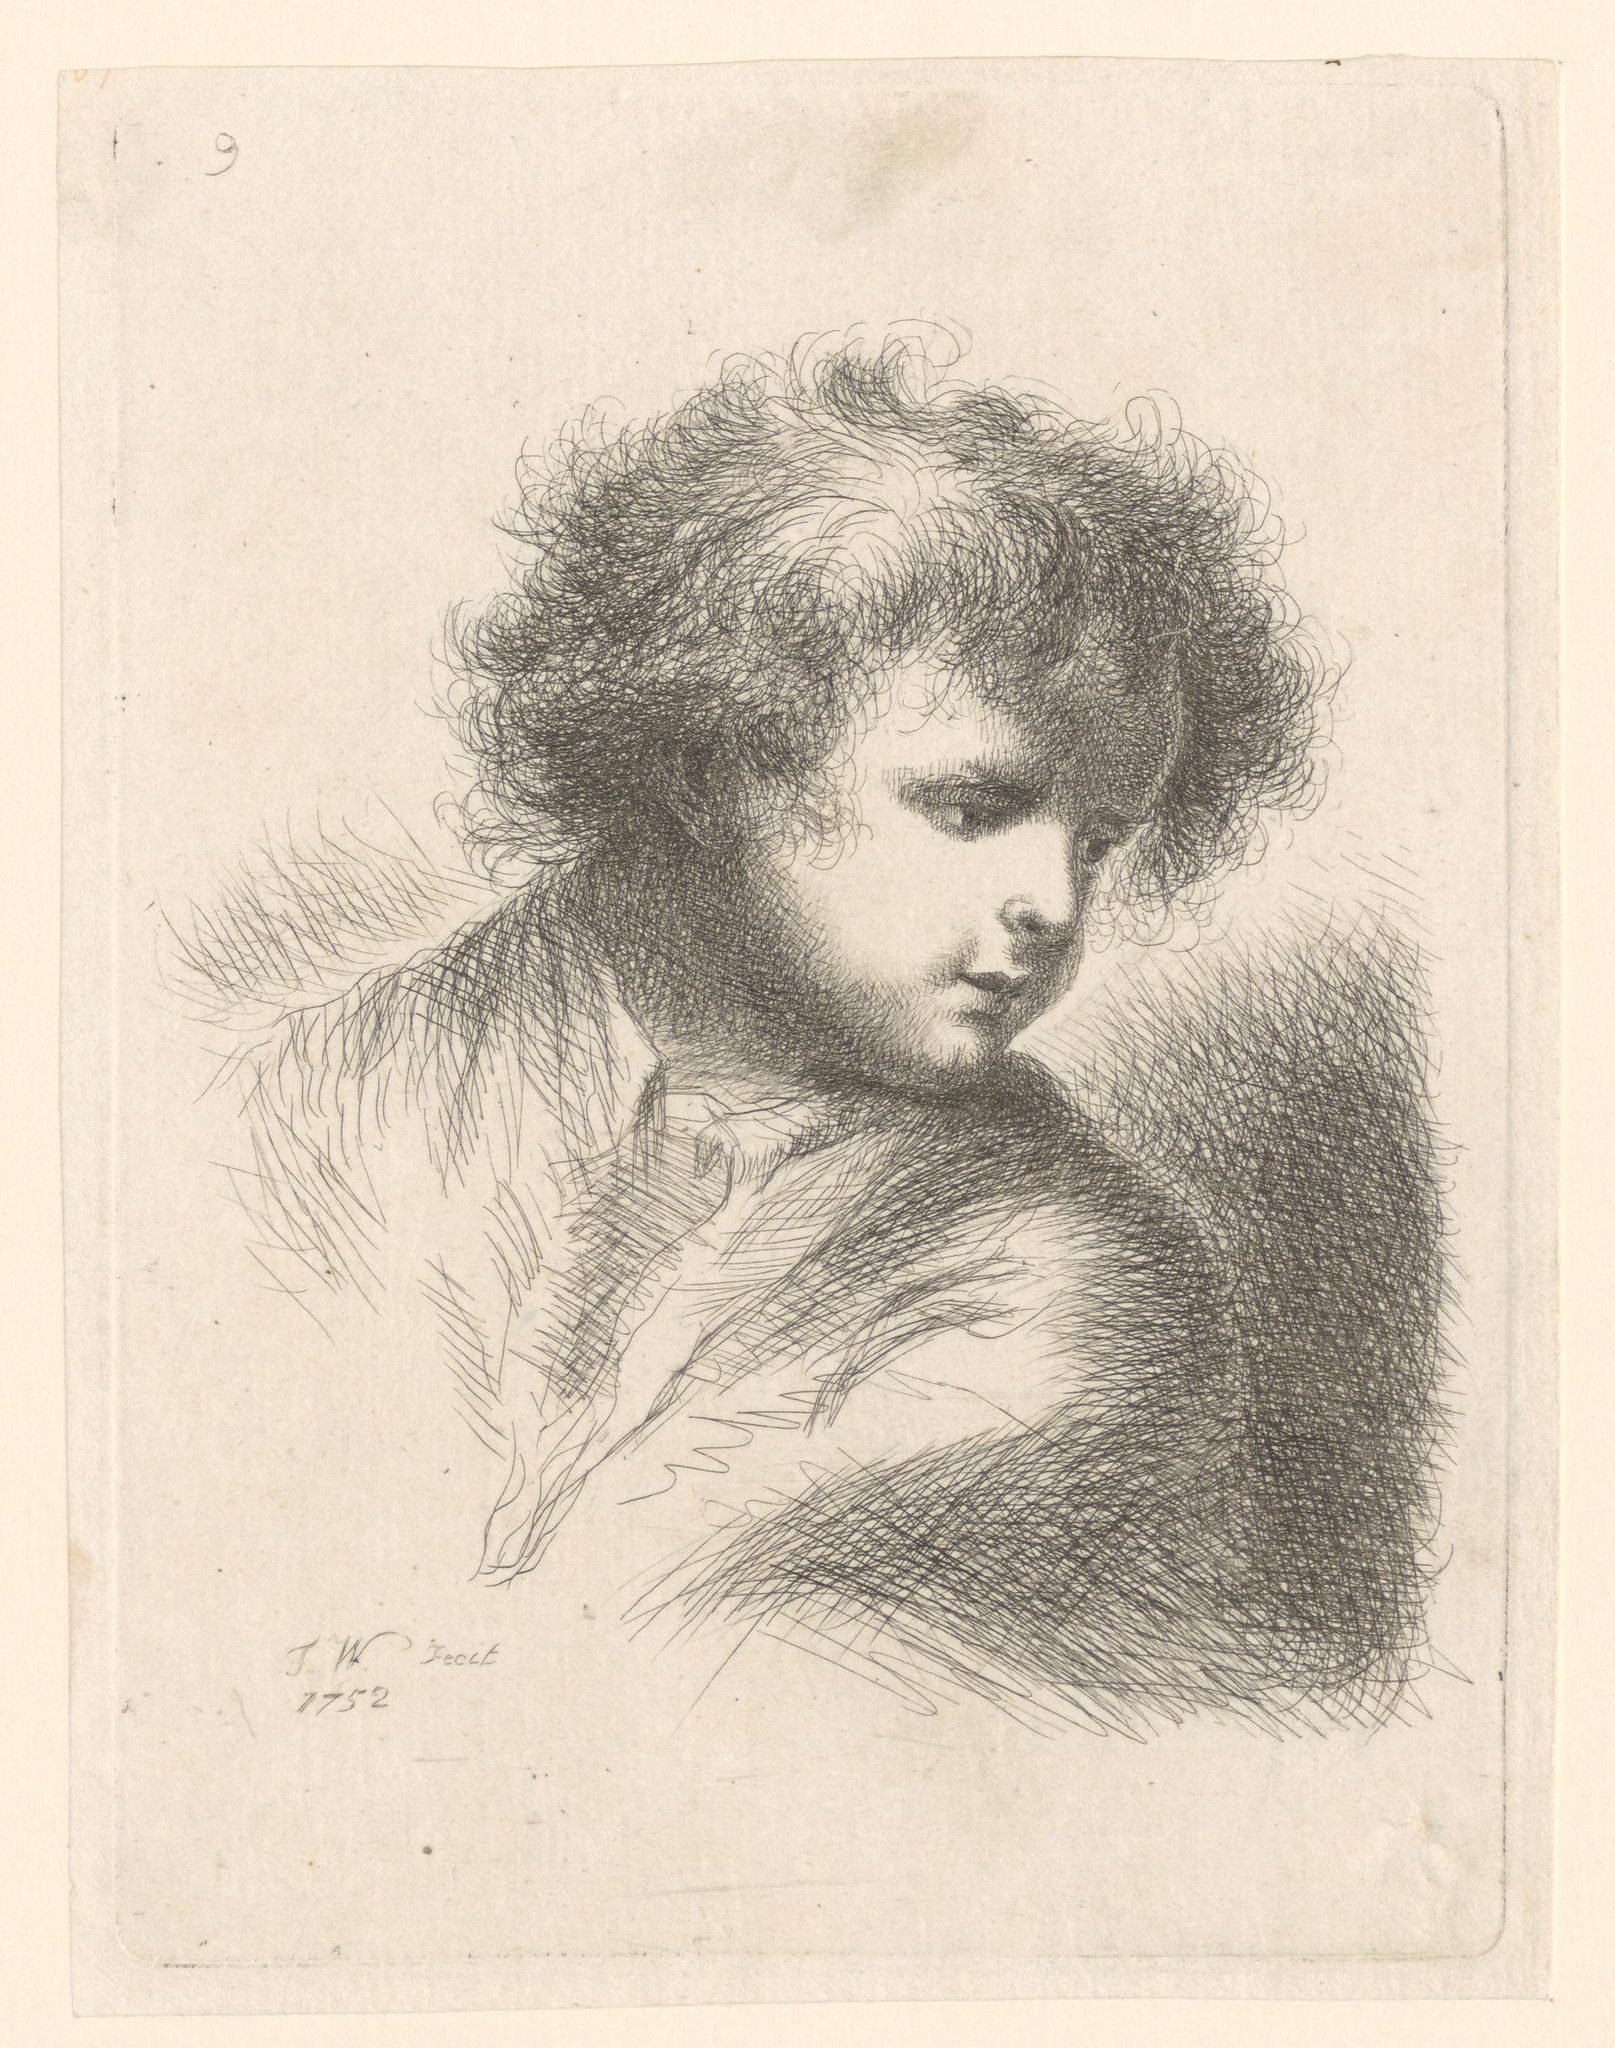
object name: print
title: Hoofd van een jongen, rechts naar beneden kijkend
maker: thomas worlidge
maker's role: print maker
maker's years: 1700-1766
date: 1752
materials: paper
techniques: etching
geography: london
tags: boy (child between toddler and youth)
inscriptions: collector's mark: Lugt 2228, collector's mark: Lugt 2760